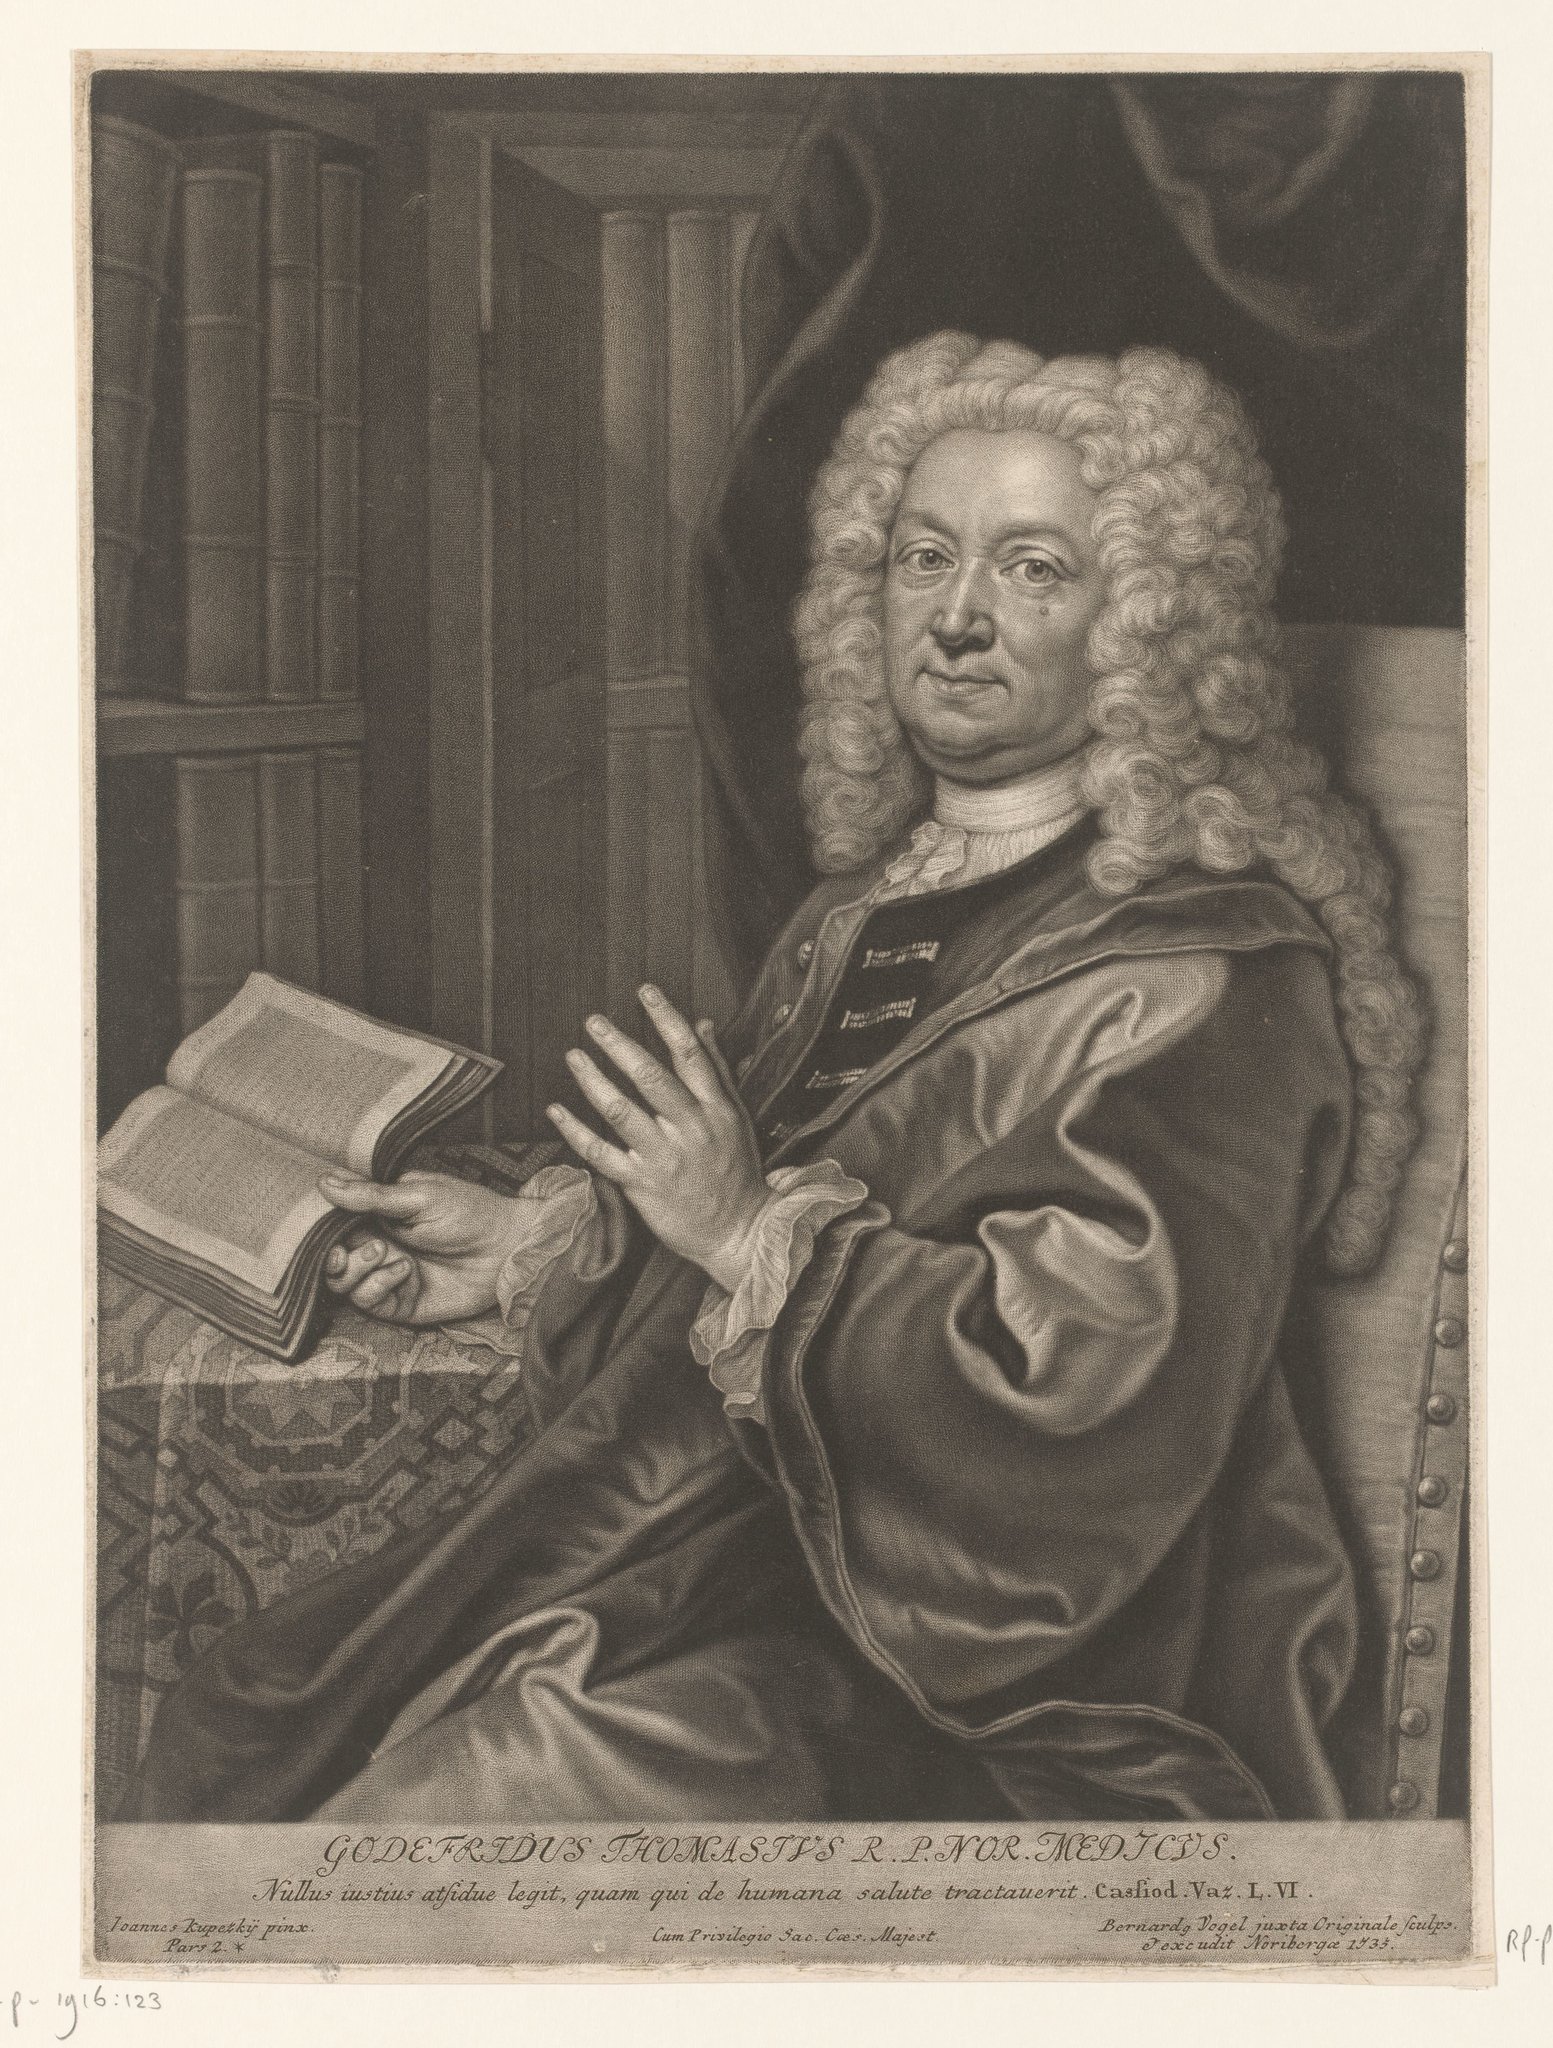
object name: print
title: Portret van Godfried Thomas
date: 1735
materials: paper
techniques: mezzotint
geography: nuremberg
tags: historical persons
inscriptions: collector's mark: Lugt 2228